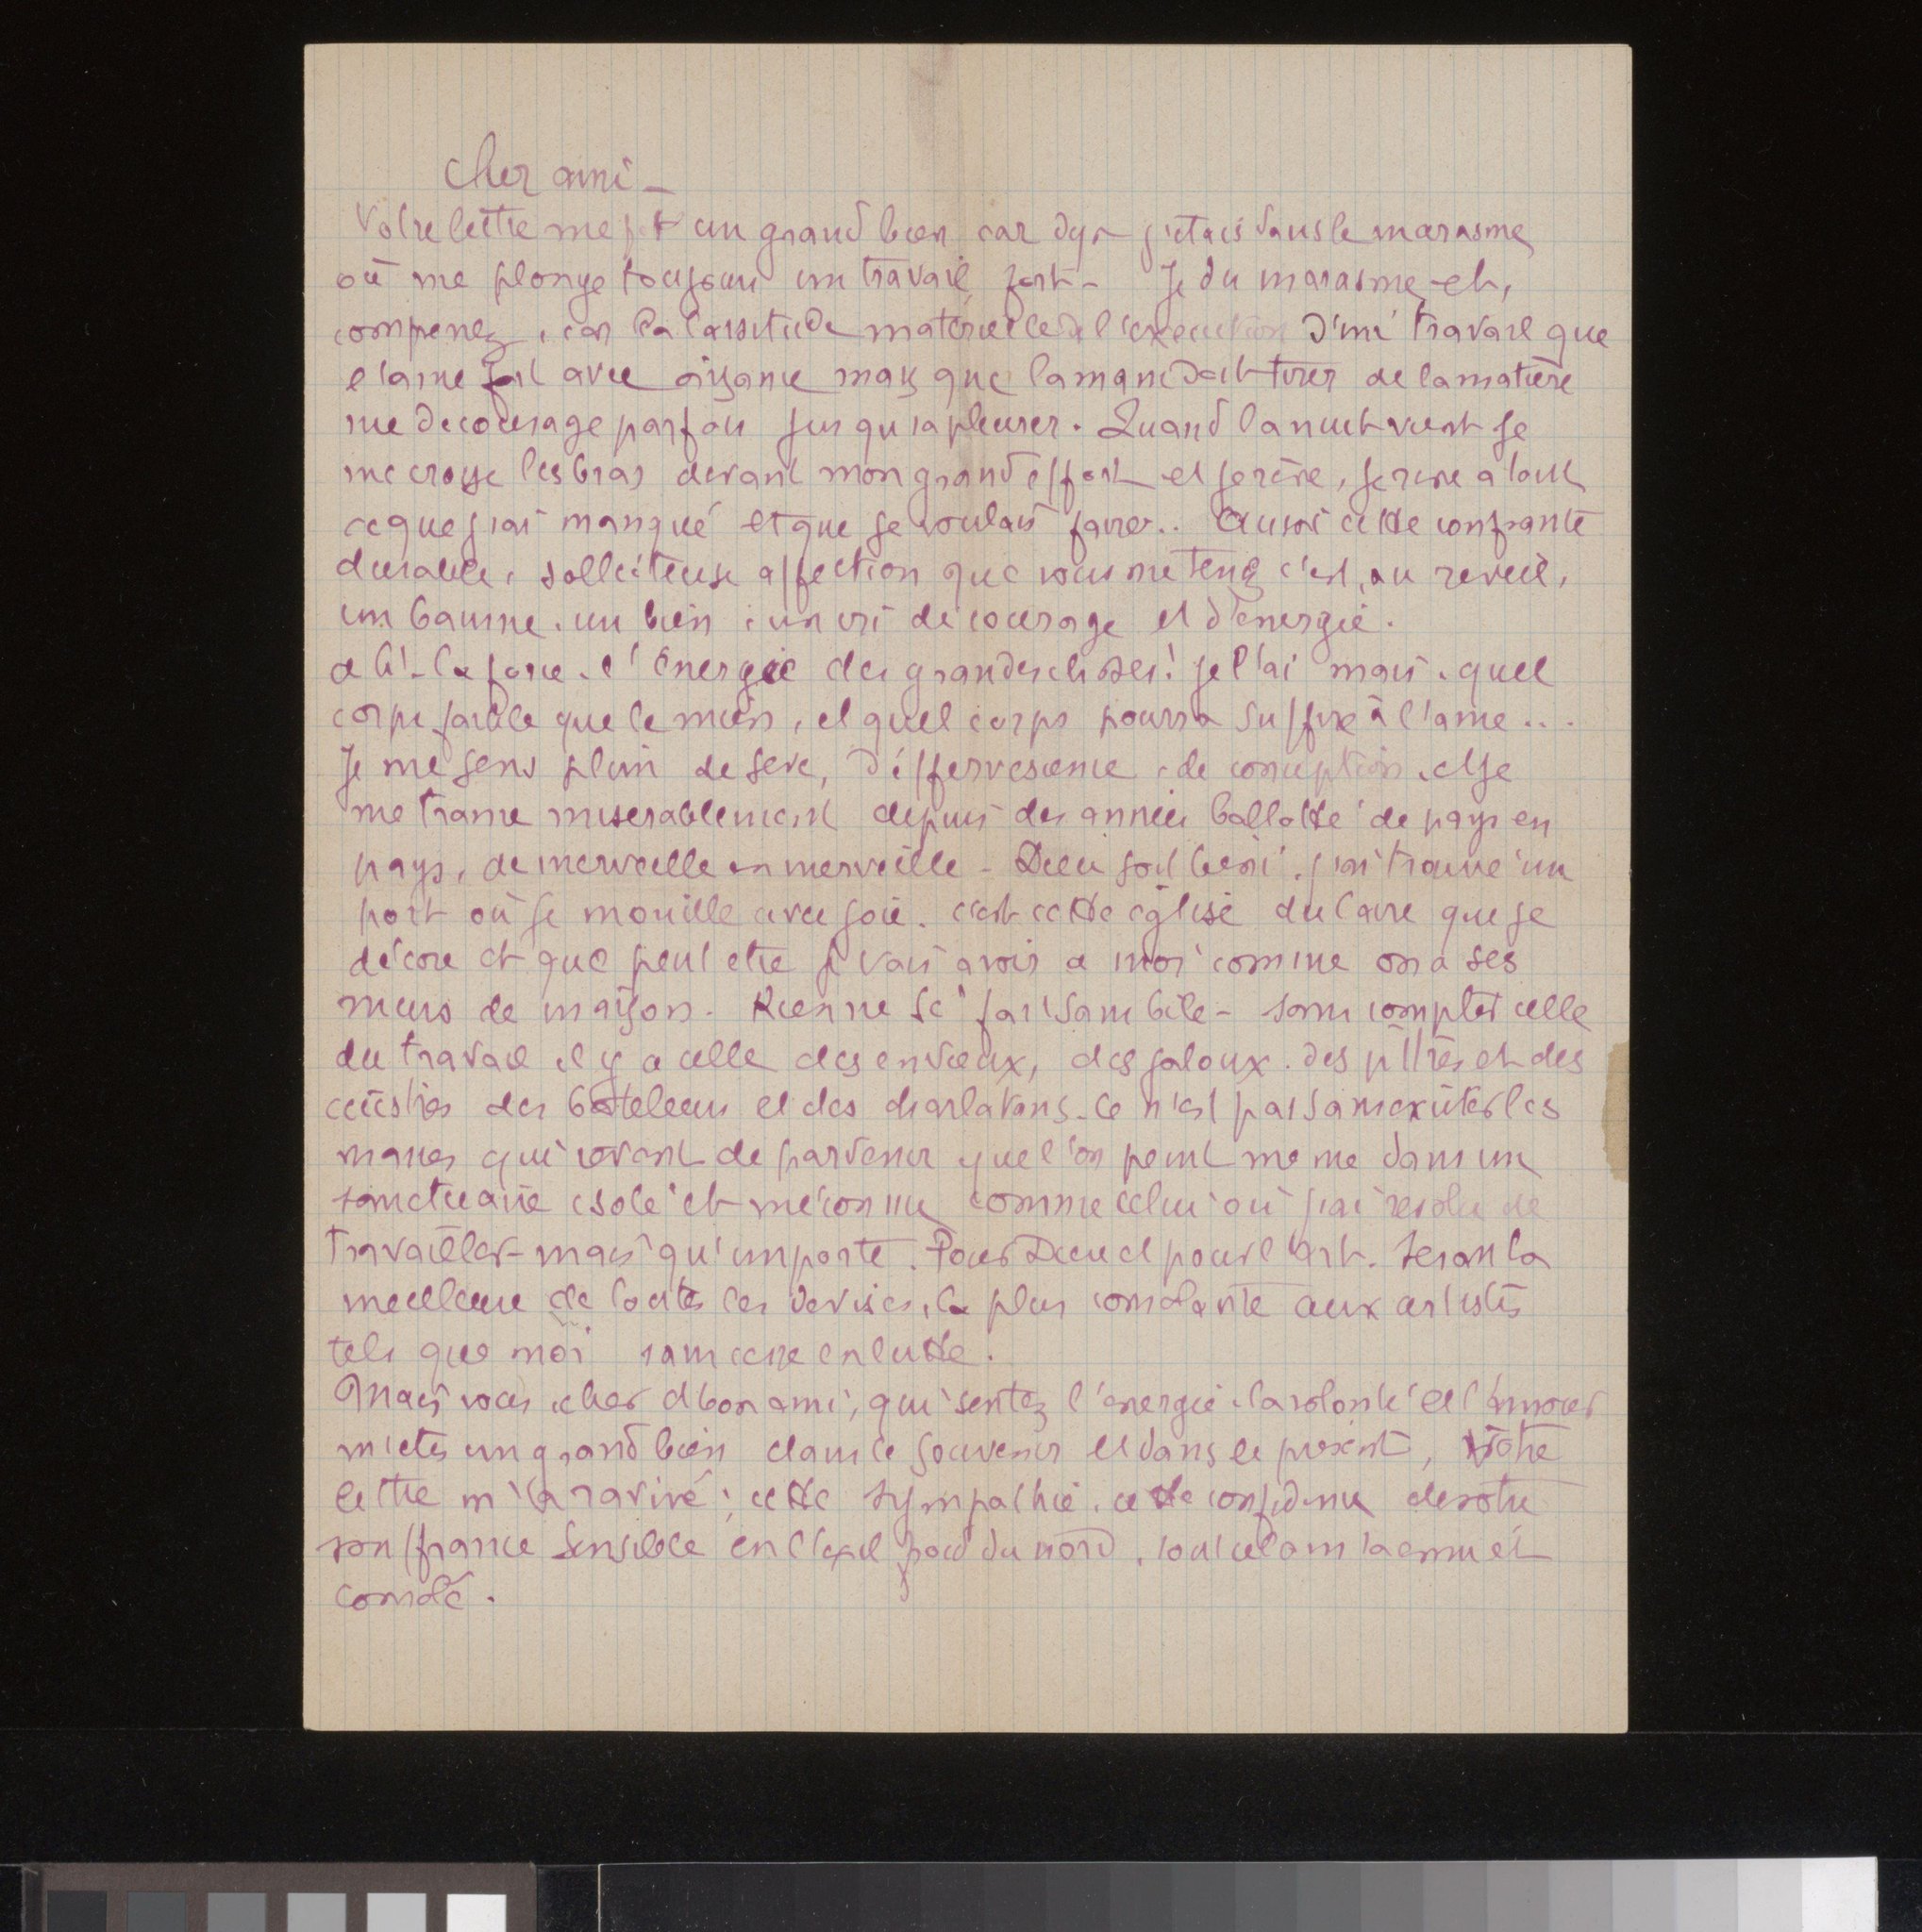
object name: letter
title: Brief aan Andries Bonger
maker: émile bernard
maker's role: print maker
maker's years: 1868-1941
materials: ink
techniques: pen, writing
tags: rafaël, daniele da volterra, sevilla, diego rodriguez de silva y velázquez, correggio, albert besnard, annibale carracci, paul gauguin, paul cézanne, leiden, amsterdam, painter, print maker, draughtsman, rembrandt van rijn, london, thomas gainsborough, rome, sculptor, michelangelo, venice, titiaan, paris, jules chéret, andries bonger, artist, leonardo da vinci, agostino carracci, édouard vuillard, maurice denis, camille mauclair, passions, emotions, affections, music, literature ~ arts, the graphic arts, italy, france, england